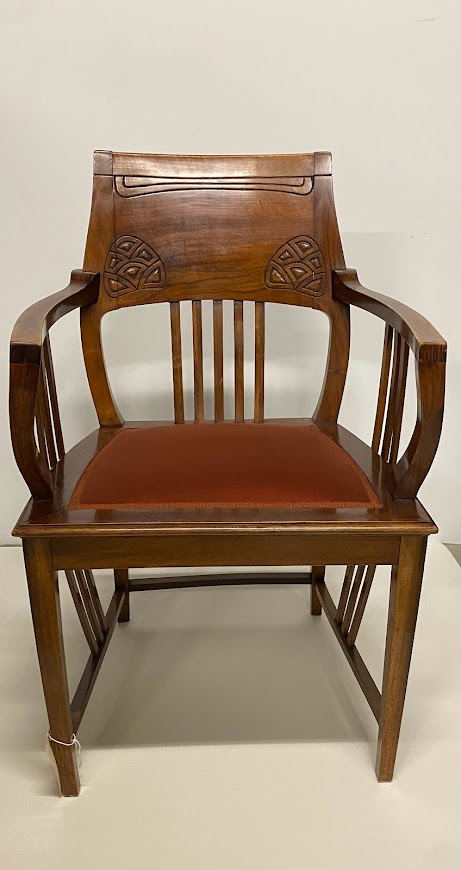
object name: armchair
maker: joseph maria olbrich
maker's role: designer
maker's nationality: austrian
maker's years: 1867-1908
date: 1898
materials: wood